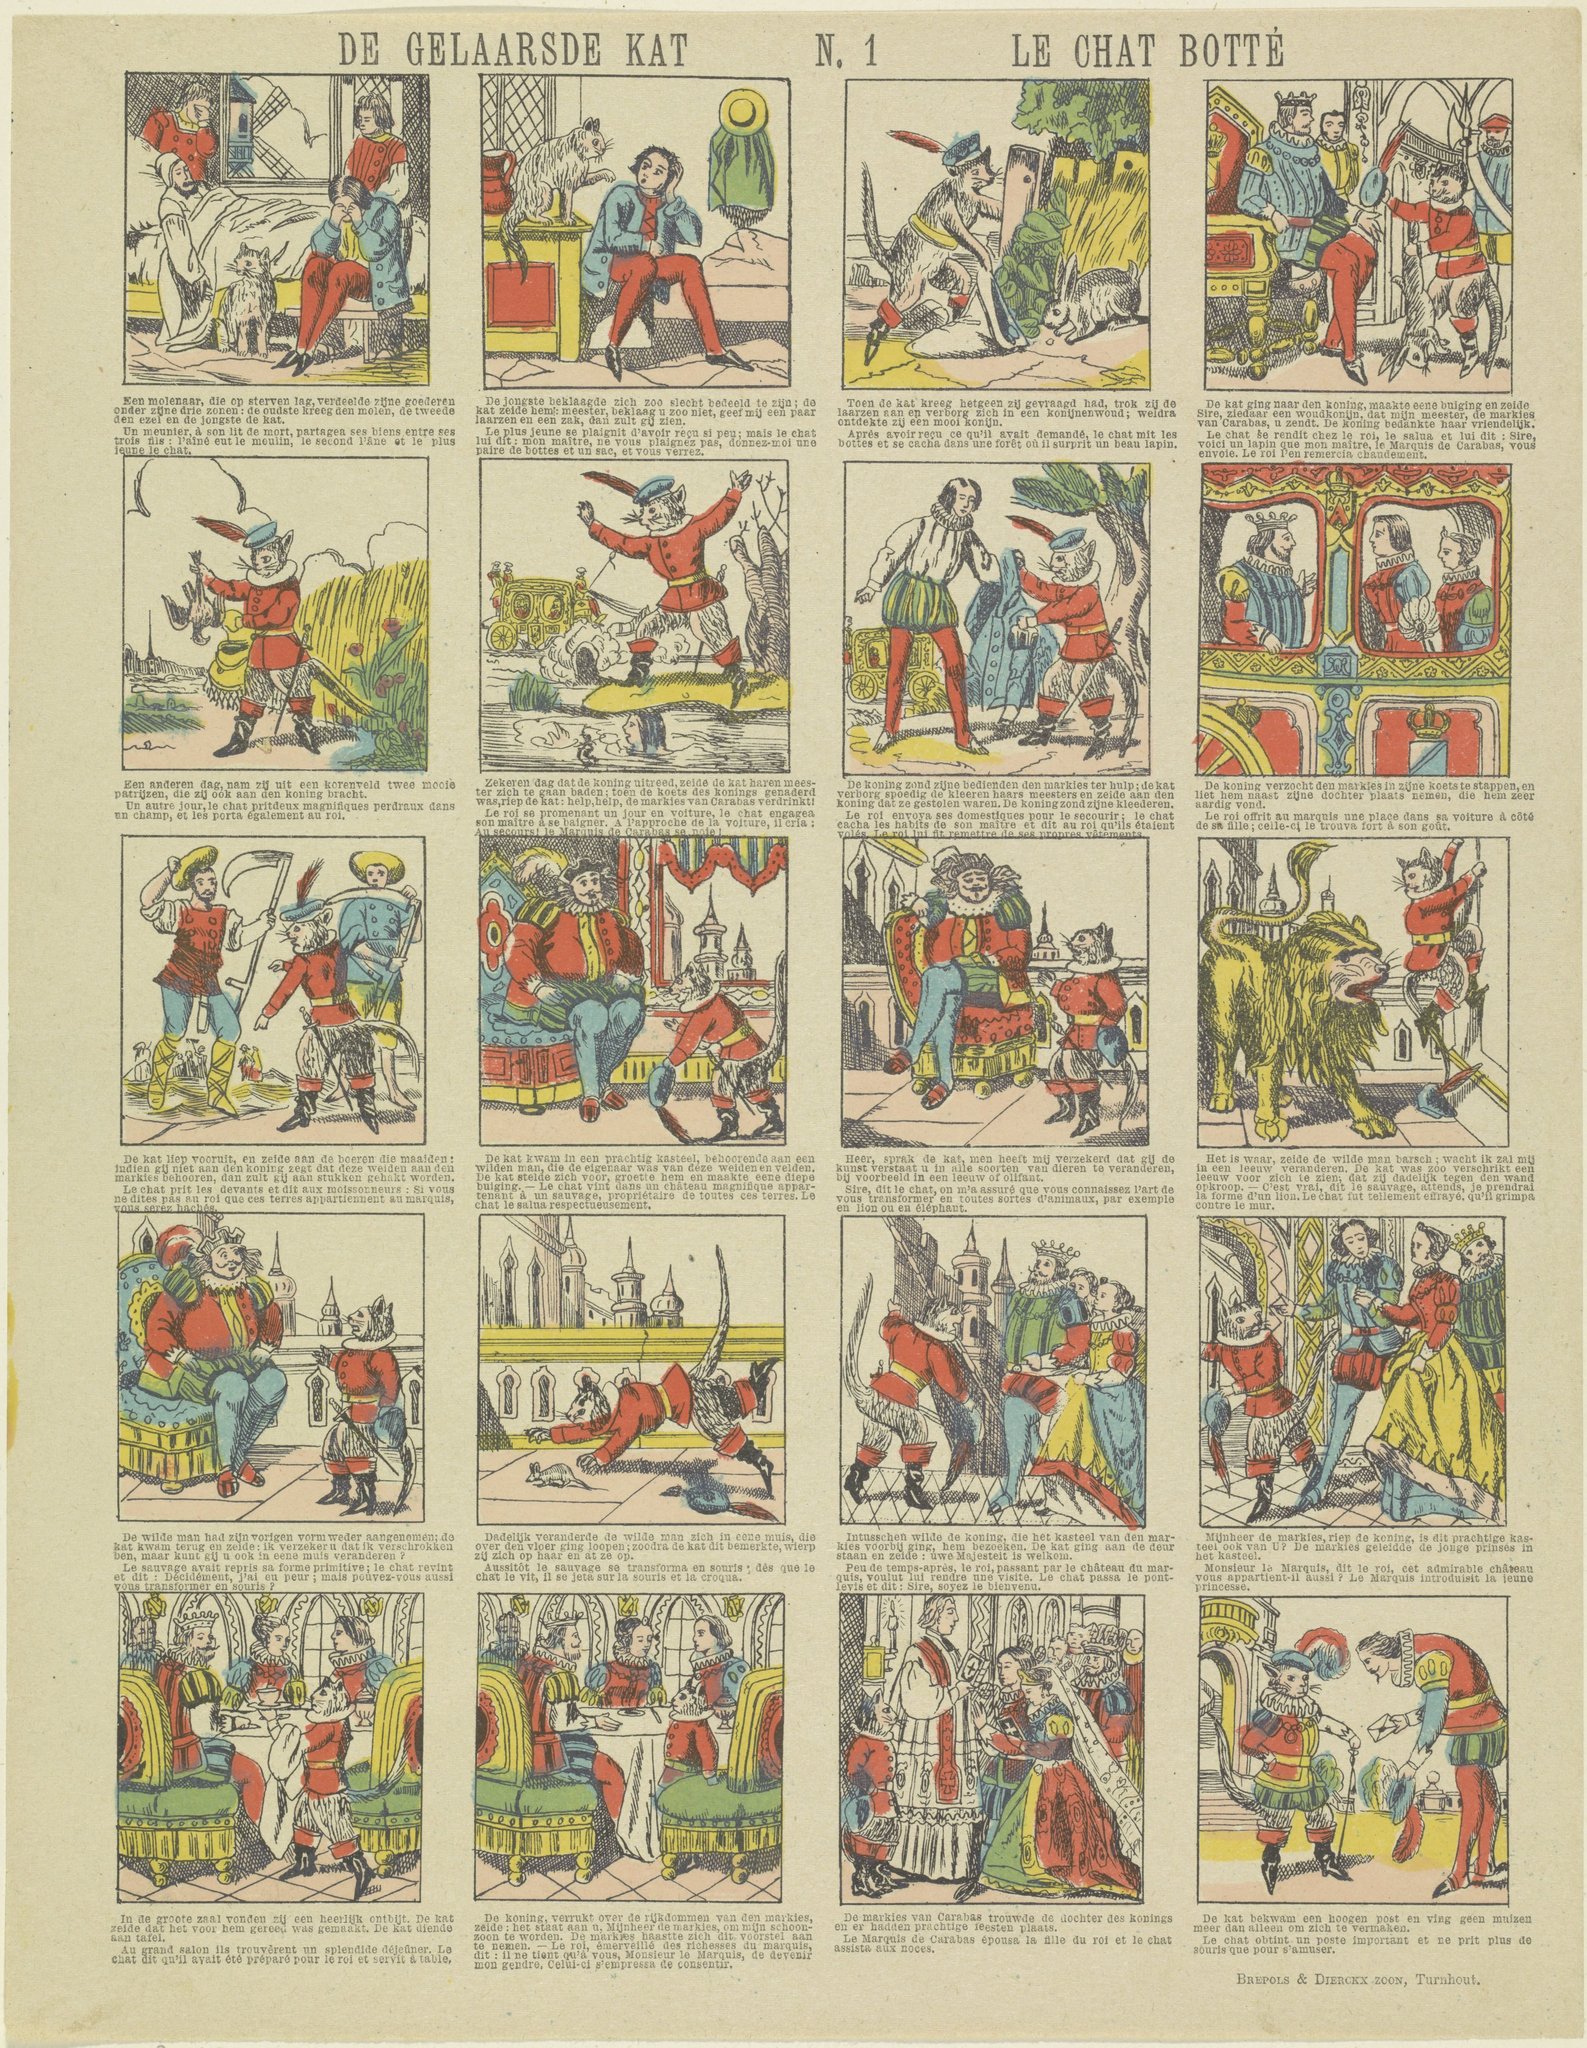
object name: popular print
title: De gelaarsde kat / Le chat botté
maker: Anonymous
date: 1833-1911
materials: paper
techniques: lithograph, letterpress printing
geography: turnhout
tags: tales and fairy tales, representations ~ goddesses, demi-goddesses, heroines, etc. (non-christian religions)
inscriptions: collector's mark: Lugt 2760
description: Blad met 16 voorstellingen uit het sprookje van de gelaarsde kat. Onder elke afbeelding een onderschrift in het Nederlands en in het Frans. Genummerd midden boven: N. 1.